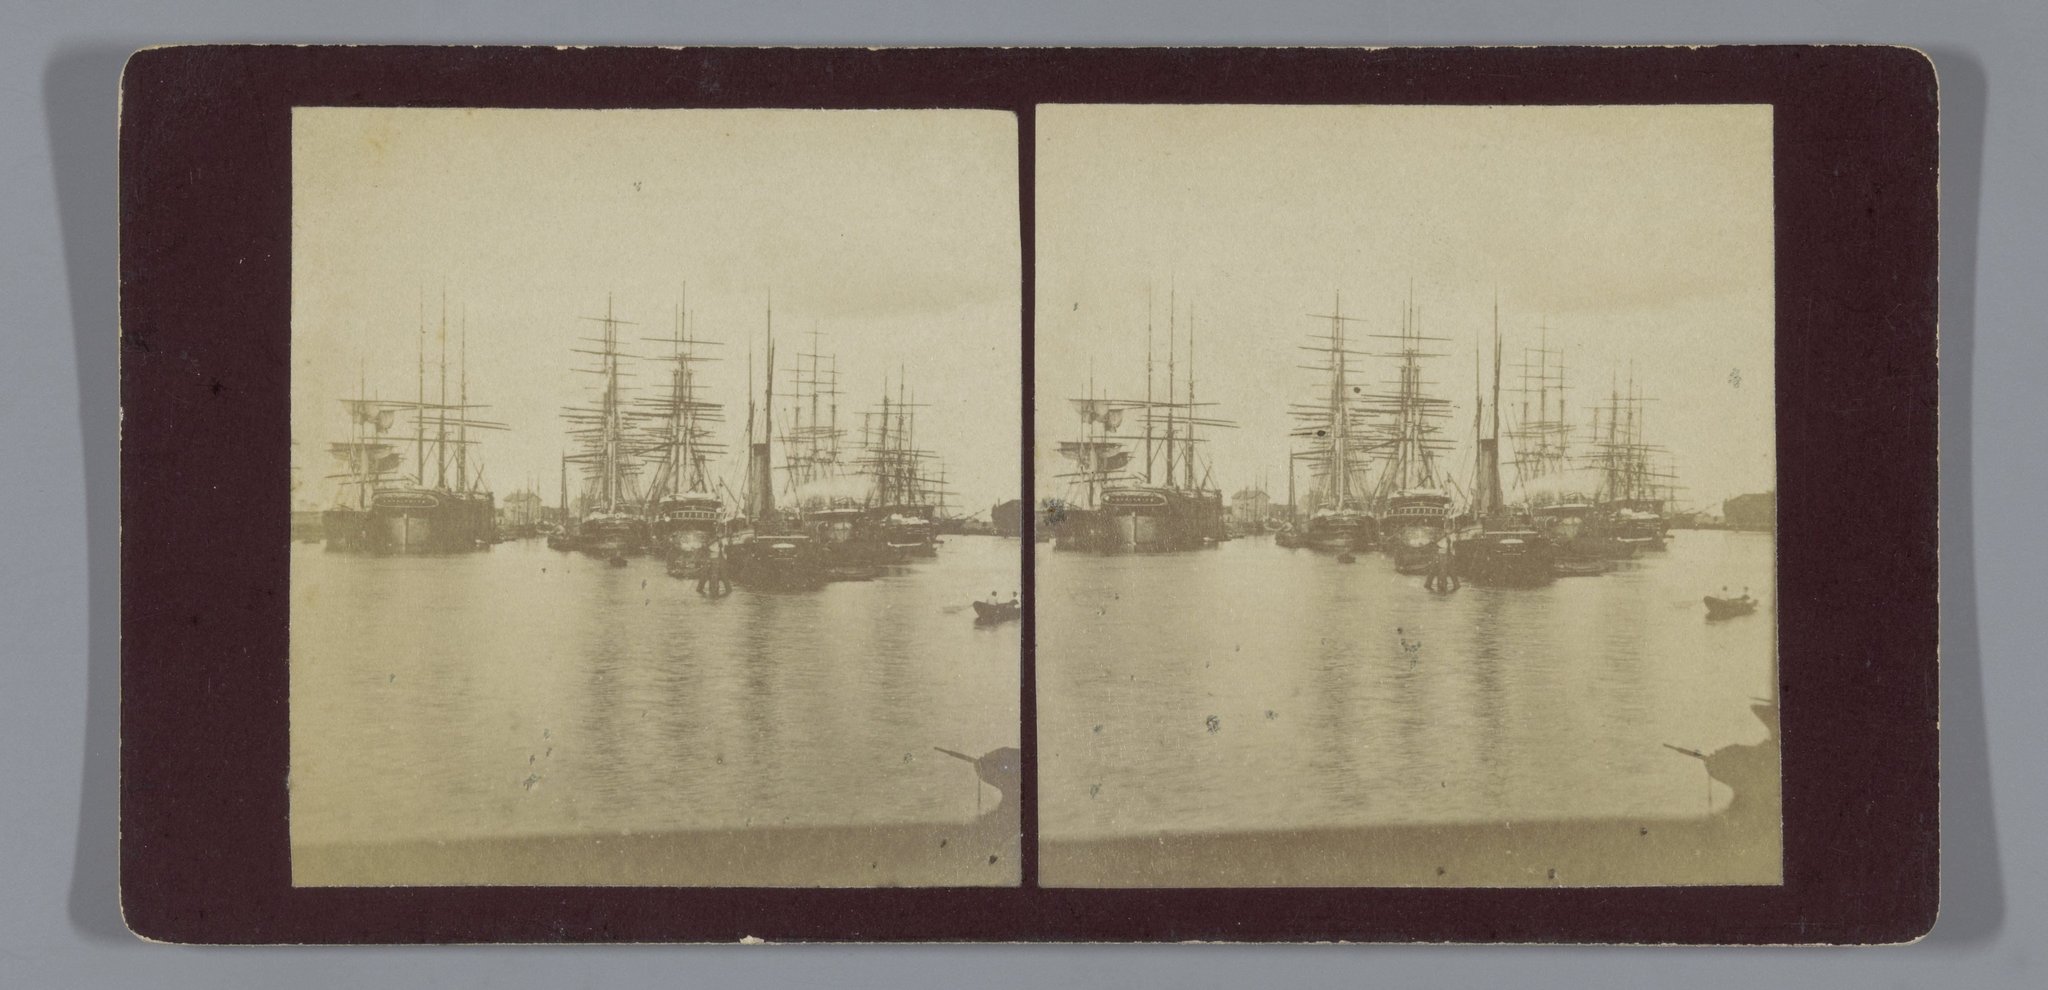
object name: stereograph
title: Zeilschepen in een haven, waarschijnlijk Amsterdam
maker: Anonymous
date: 1902-1910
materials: cardboard, paper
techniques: albumen print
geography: amsterdam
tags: harbour, port of amsterdam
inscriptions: number: ‘6’